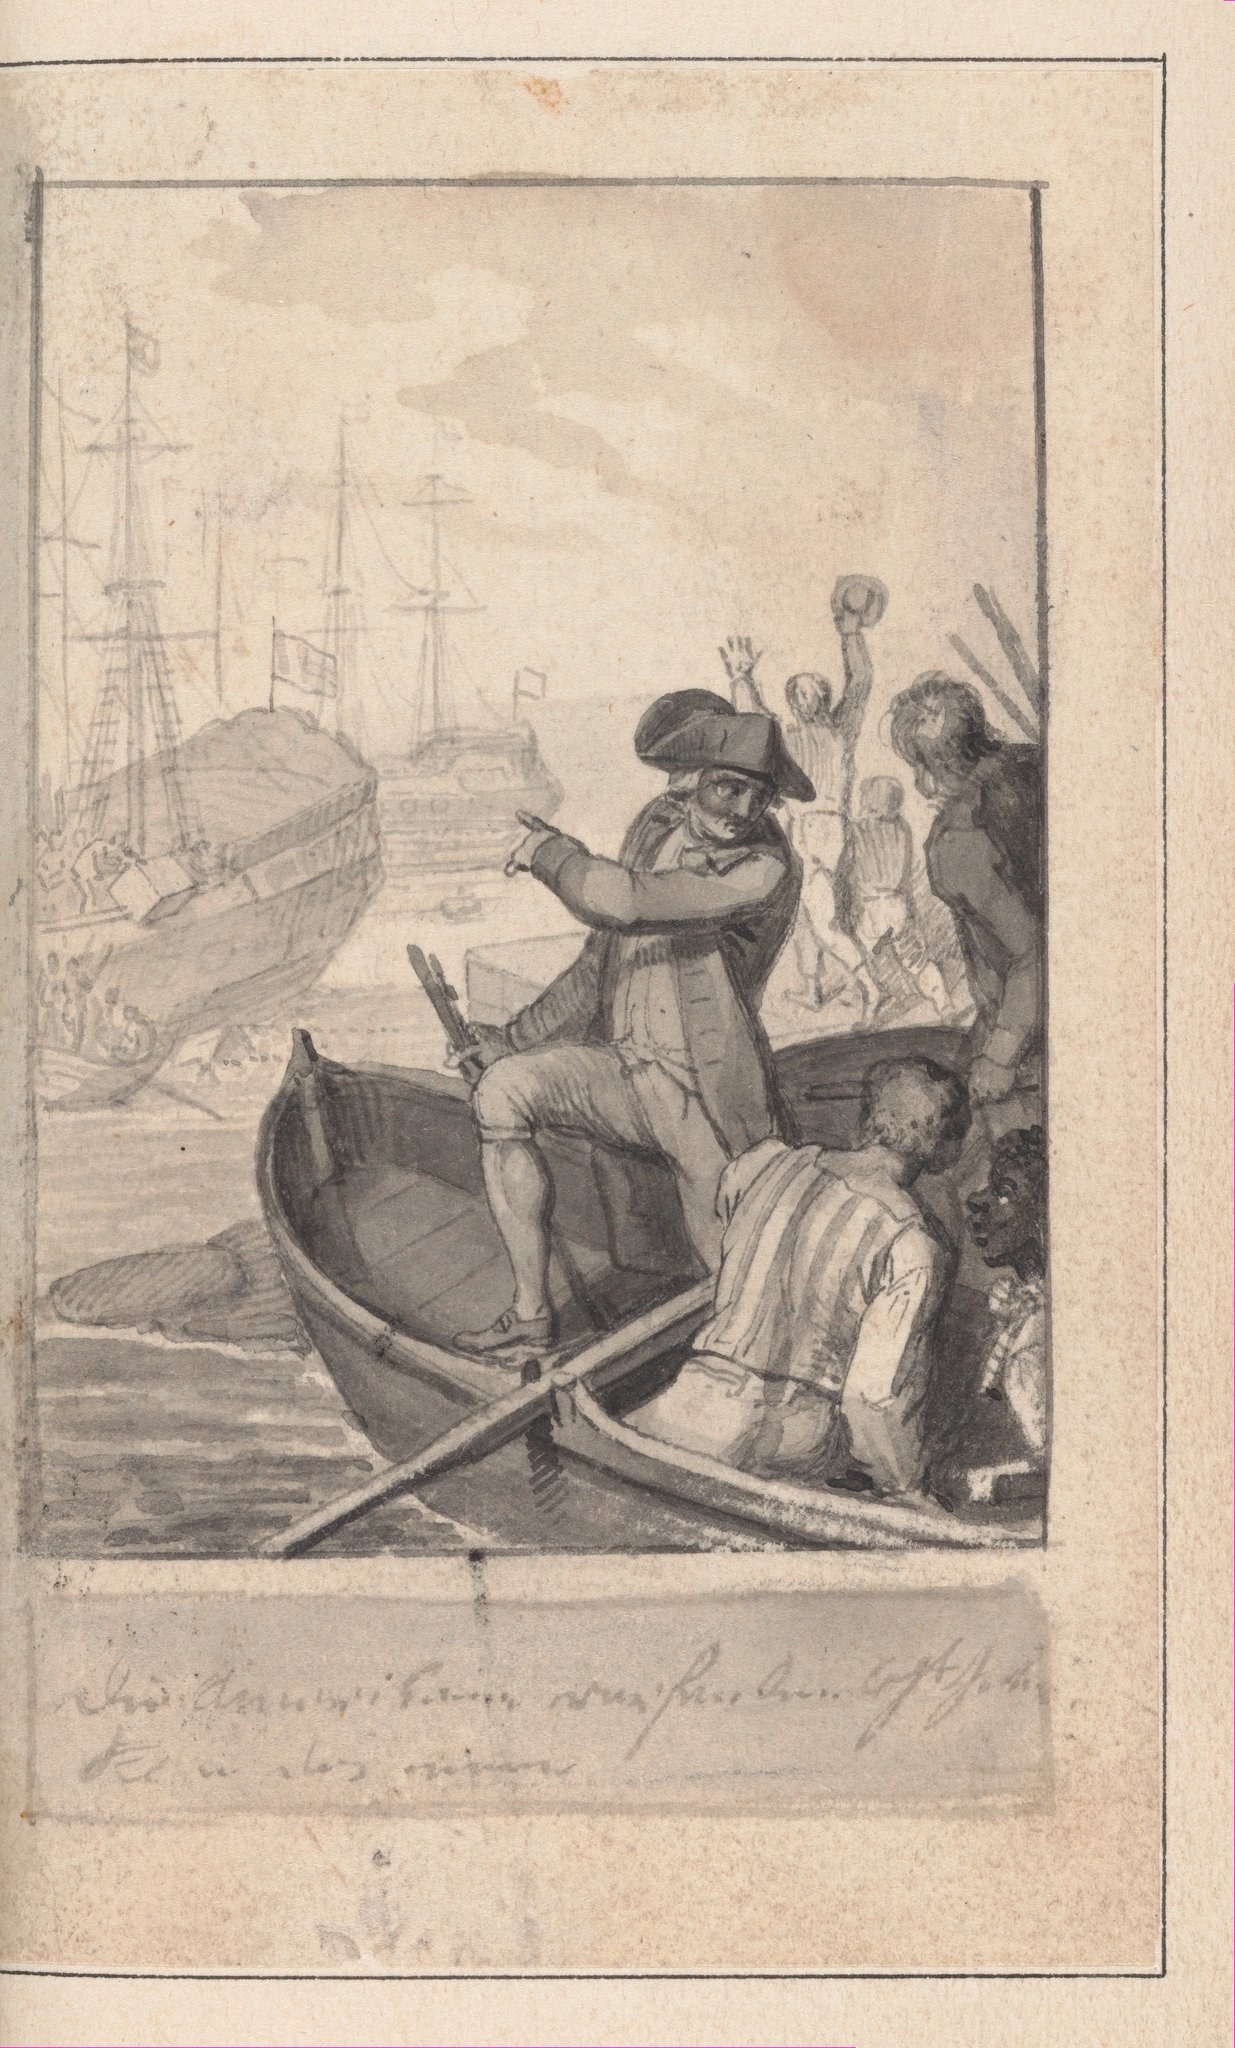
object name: book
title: Allgemeines historisches Taschenbuch, oder Abriss der merkwürdigsten neuen Welt-Begebenheiten: enthaltend für 1784 die Geschichte der Revolution von Nord-America [General historical pocketbook, summarizing noteworthy world news of 1784, with a History of the Revolution in North America]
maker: matthias christian sprengel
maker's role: author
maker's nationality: german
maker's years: 1746-1803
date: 1784-1787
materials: ink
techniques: drawing, engraving, etching, hand coloring, pen, wash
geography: germany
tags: american revolution,men,boats